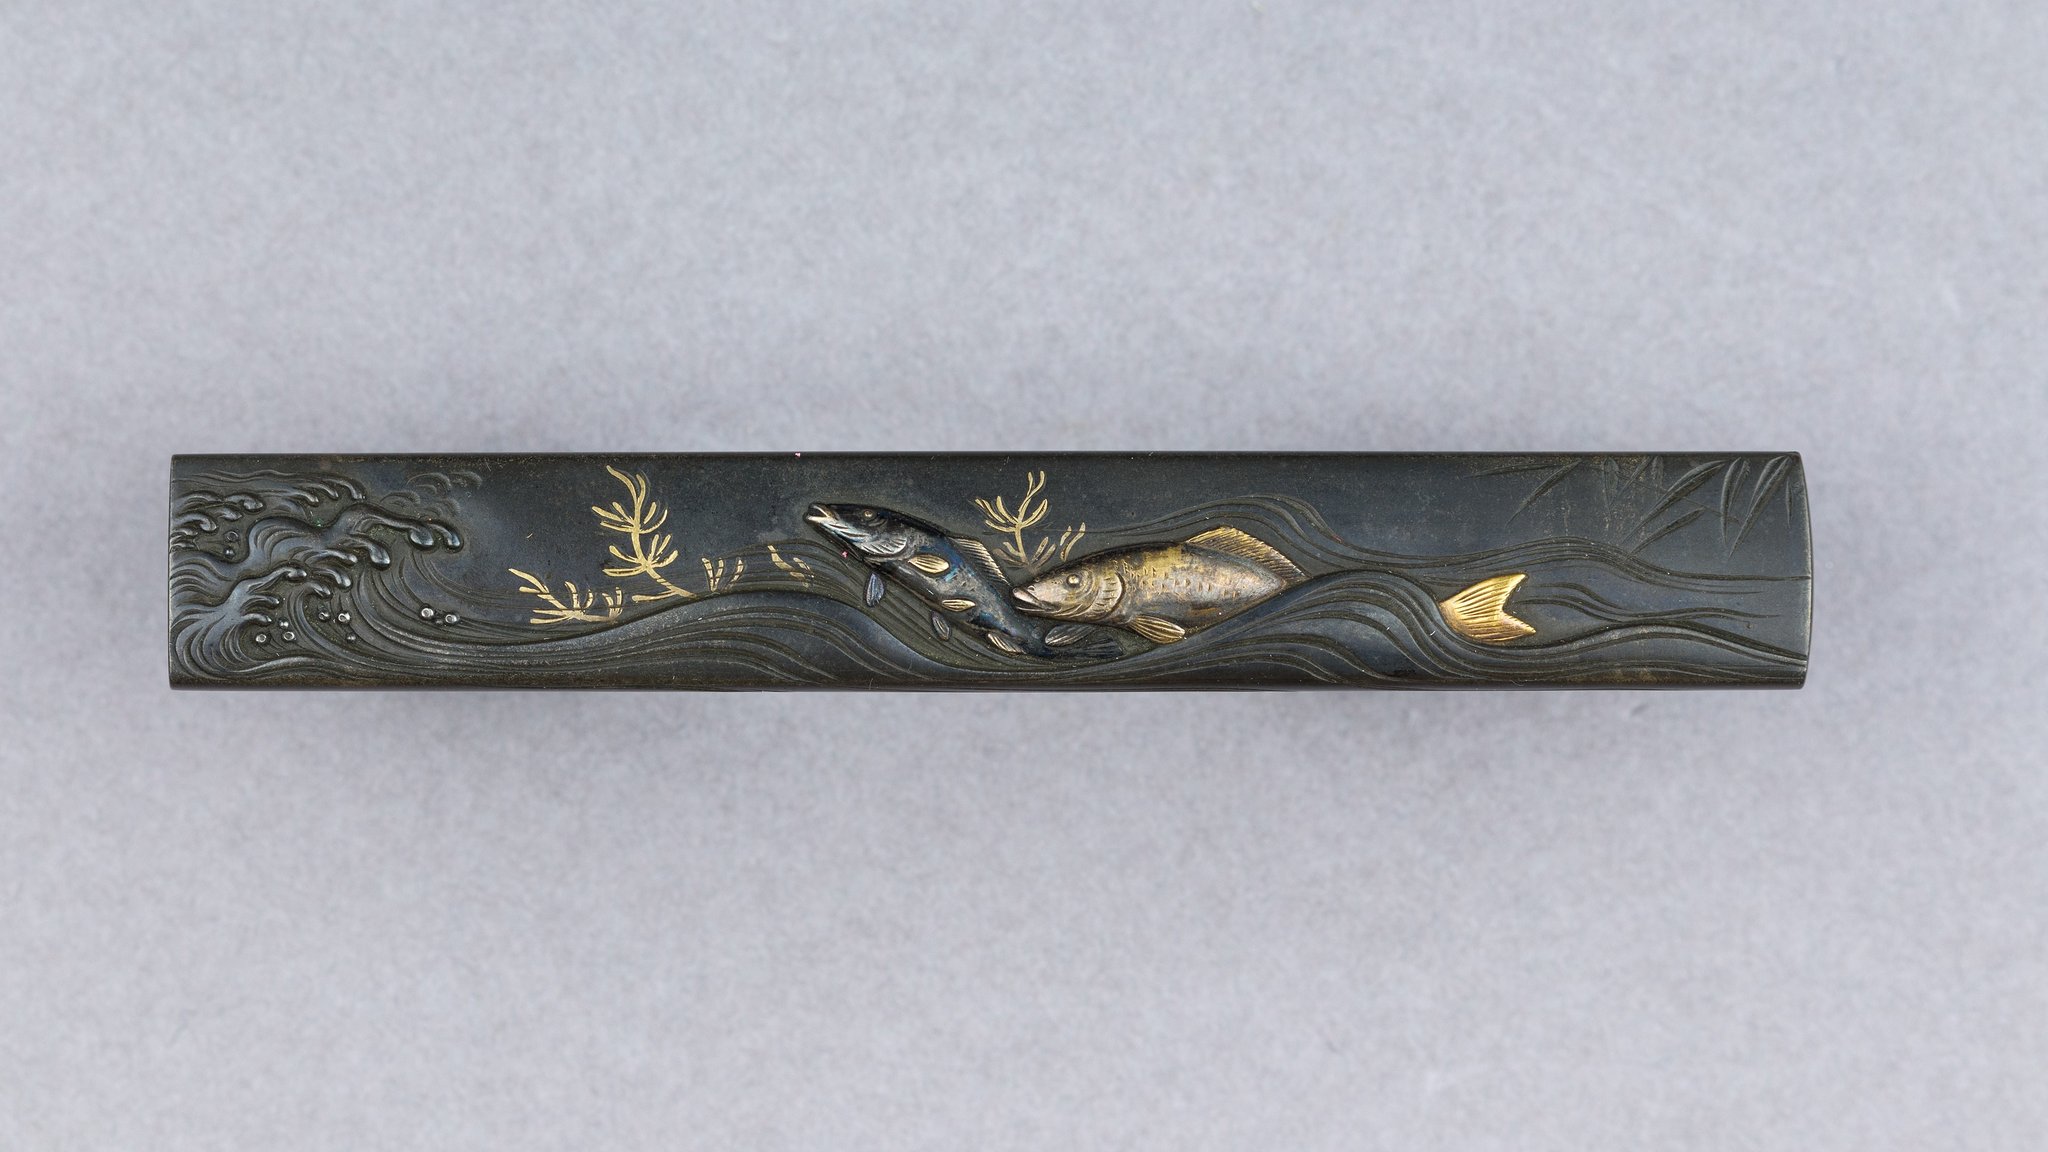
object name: knife handle kozuka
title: Knife Handle (Kozuka)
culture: japanese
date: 1701-1800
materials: silver alloy, gold, silver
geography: japan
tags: fish